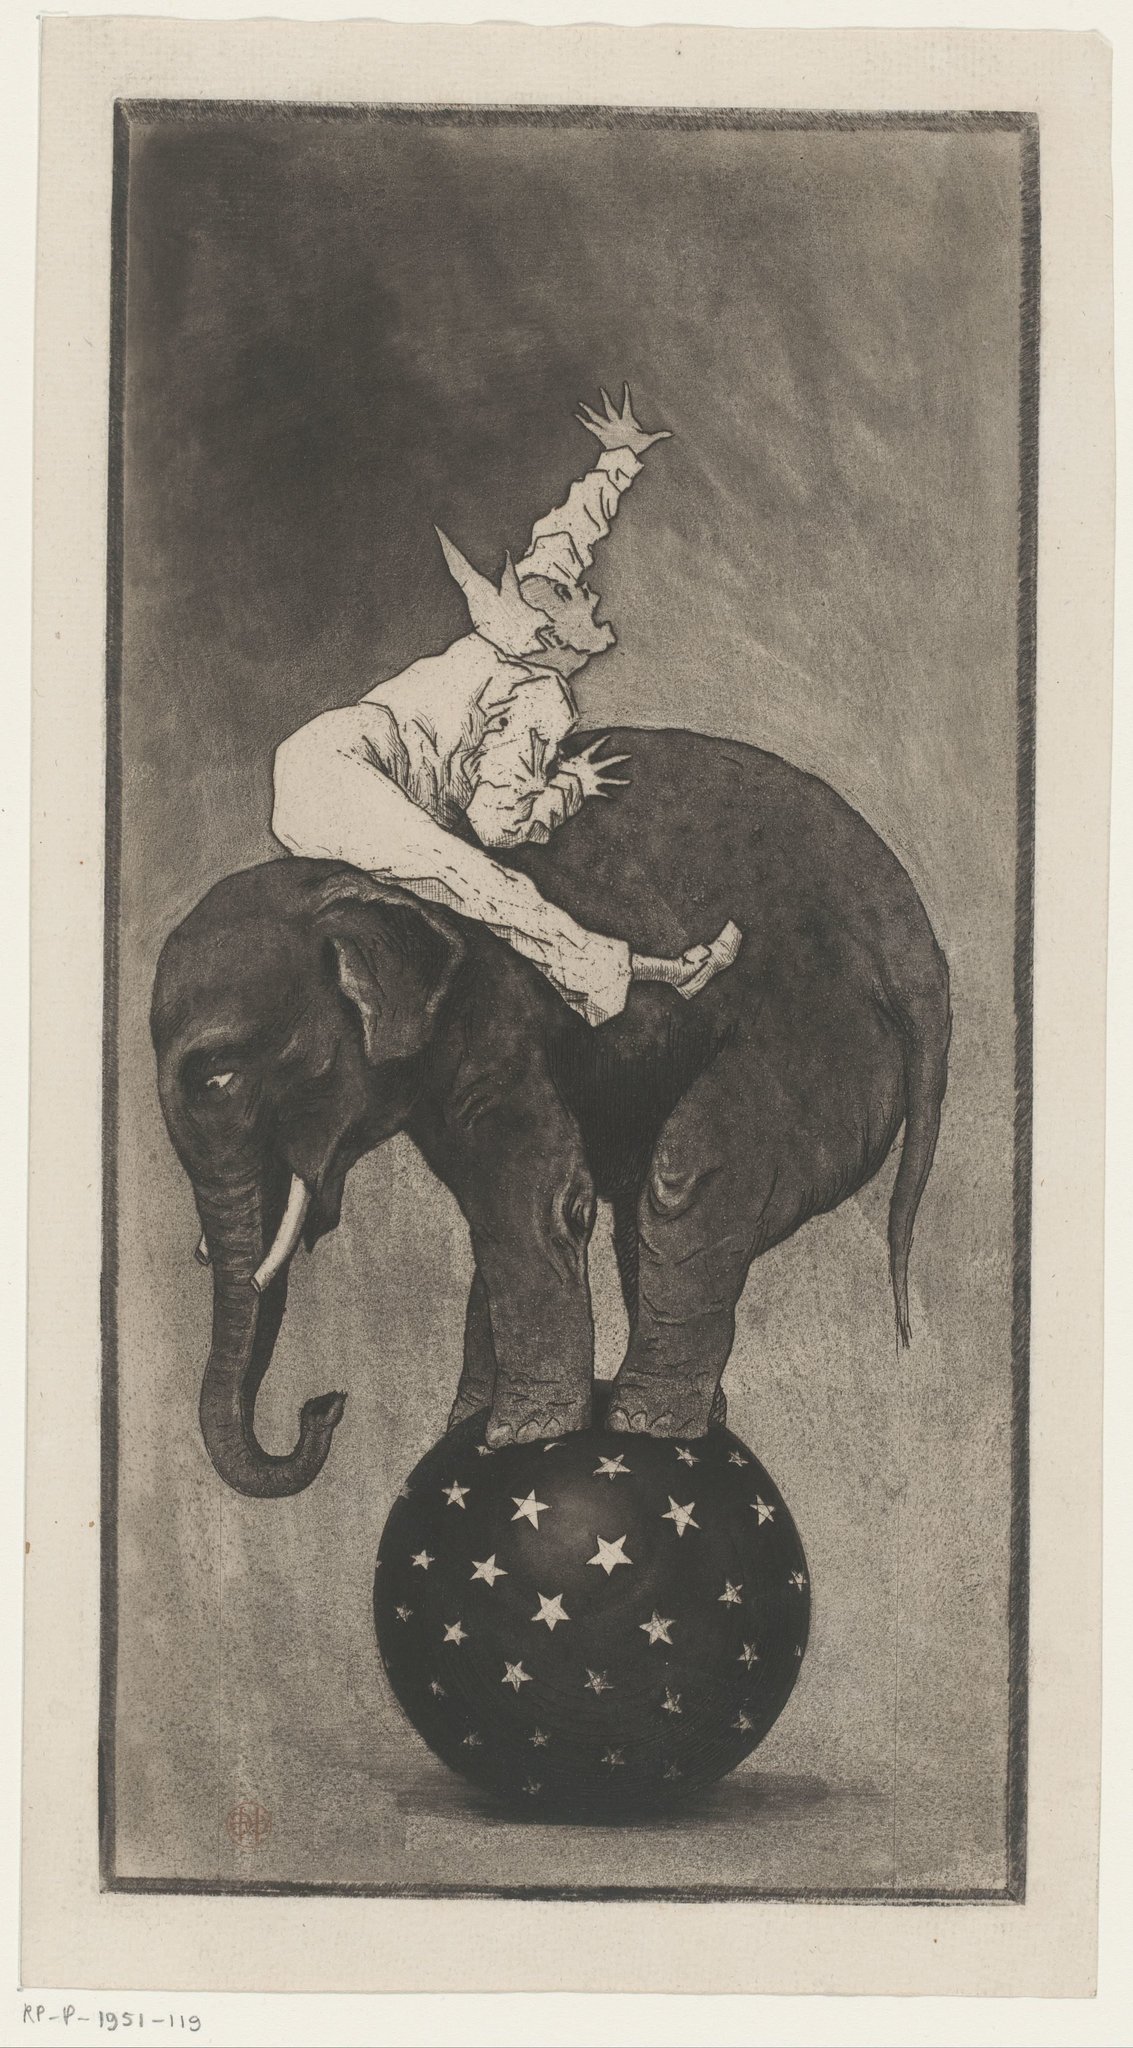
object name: print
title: Olifant balancerend op een bal met een man op zijn rug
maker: henri charles guérard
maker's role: print maker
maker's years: 1846-1897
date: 1856-1897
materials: paper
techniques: aquatint, etching, roulette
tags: elephants (circus performance), trunked animals: elephant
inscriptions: stamp: Lugt 1157, collector's mark: Lugt 2228